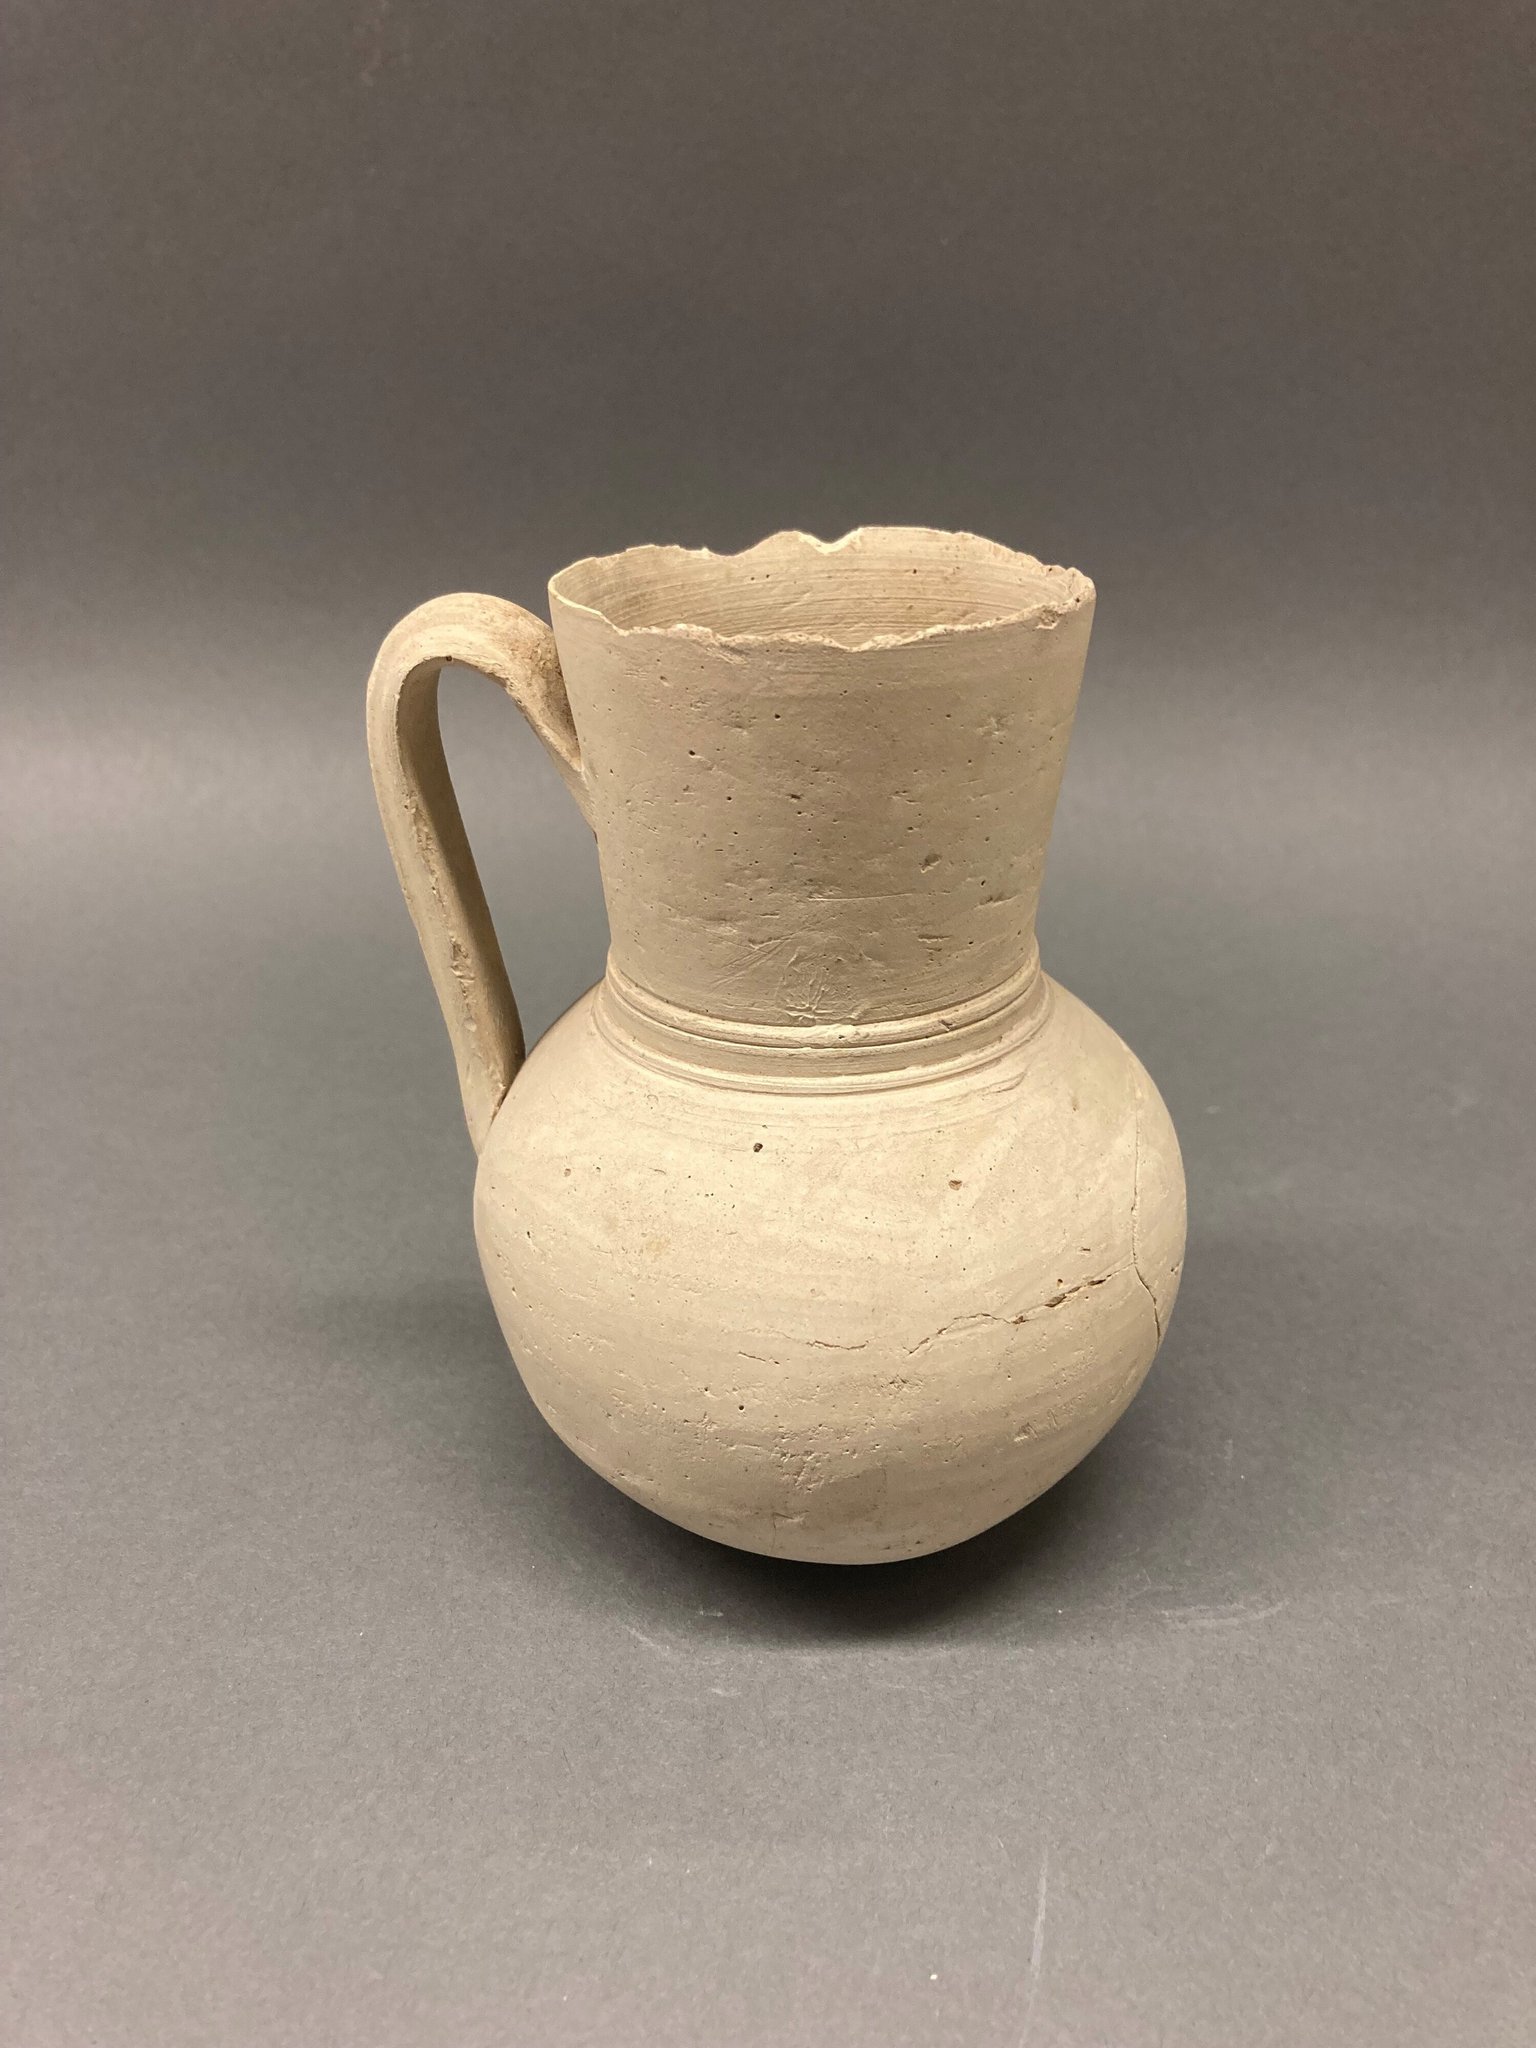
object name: ewer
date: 767-900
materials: earthenware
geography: iran